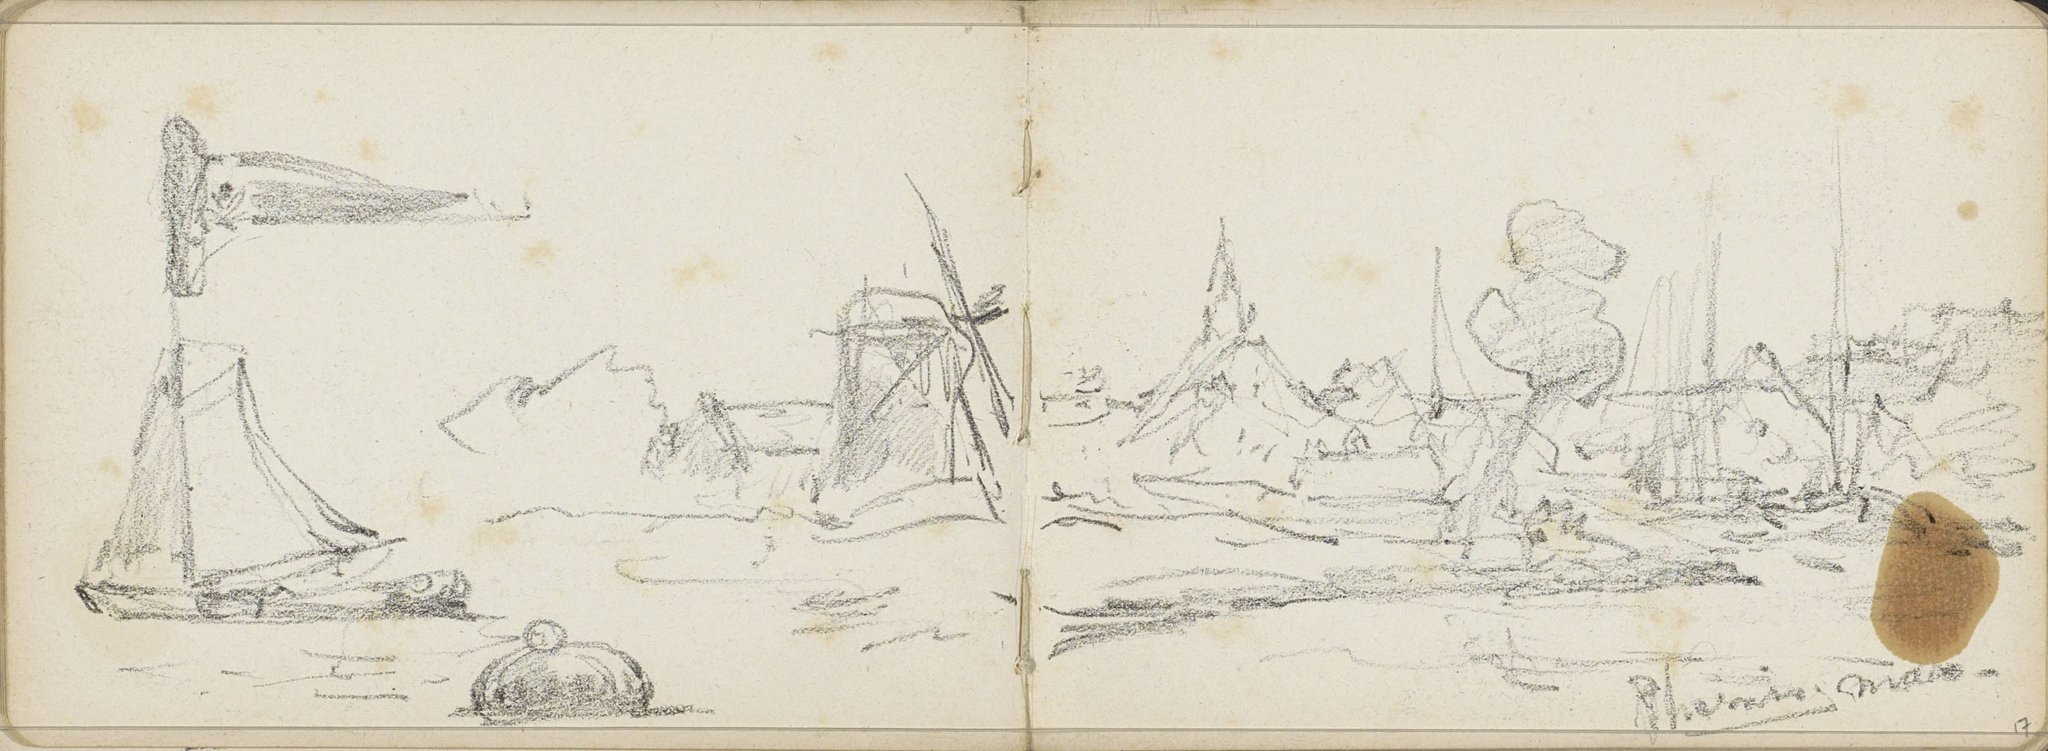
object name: sketchbook leaf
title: Zeilboten en een gezicht op een stad aan de Maas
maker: willem cornelis rip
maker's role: draughtsman, painter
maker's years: 1856-1922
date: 1866-1922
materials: chalk, paper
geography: meuse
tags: city-view, and landscape with man-made constructions, sailing-ship, sailing-boat, landscapes with waters, waterscapes, seascapes (in the temperate zone)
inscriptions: annotation: ‘Rhe[...] maas’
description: Blad 16 verso en 17 recto uit een schetsboek met 42 bladen.